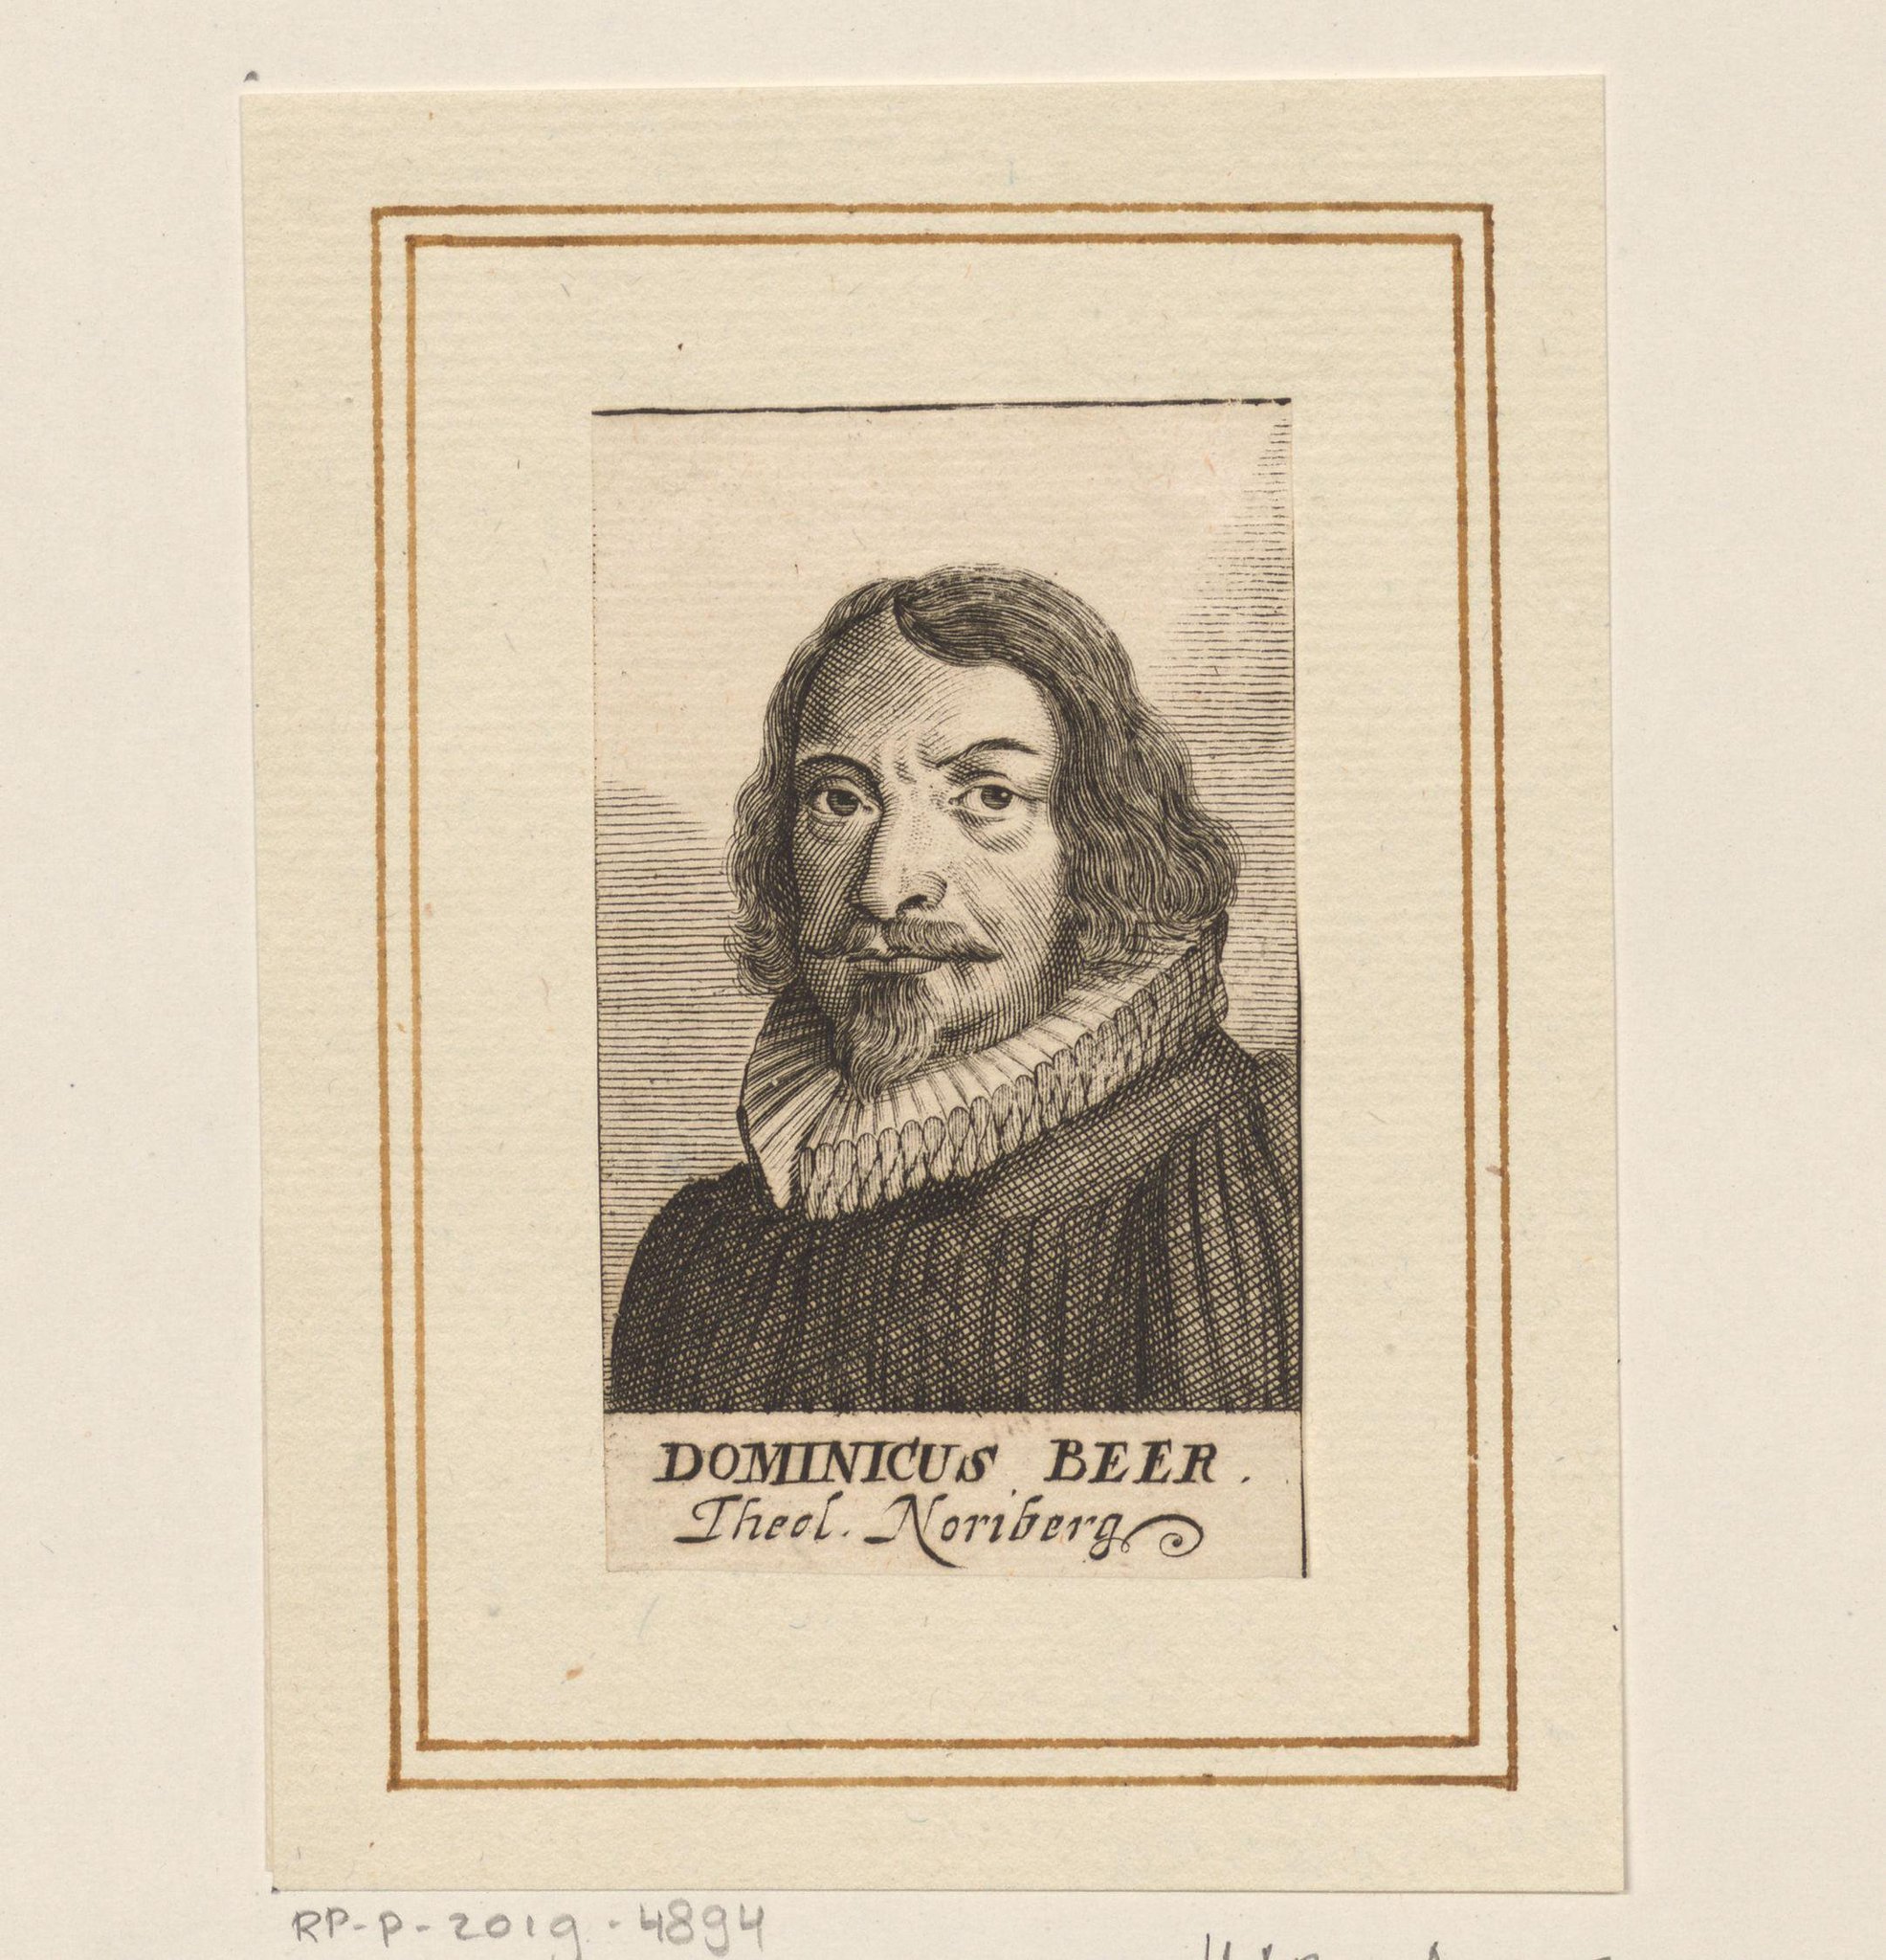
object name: book illustration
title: Portret van Dominicus Beer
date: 1688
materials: paper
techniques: engraving, etching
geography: nuremberg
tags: historical persons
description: Prent uit: Freher, Paul. Theatrum virorum eruditione clarorum. Neurenberg: Johann Hoffmann, 1688.